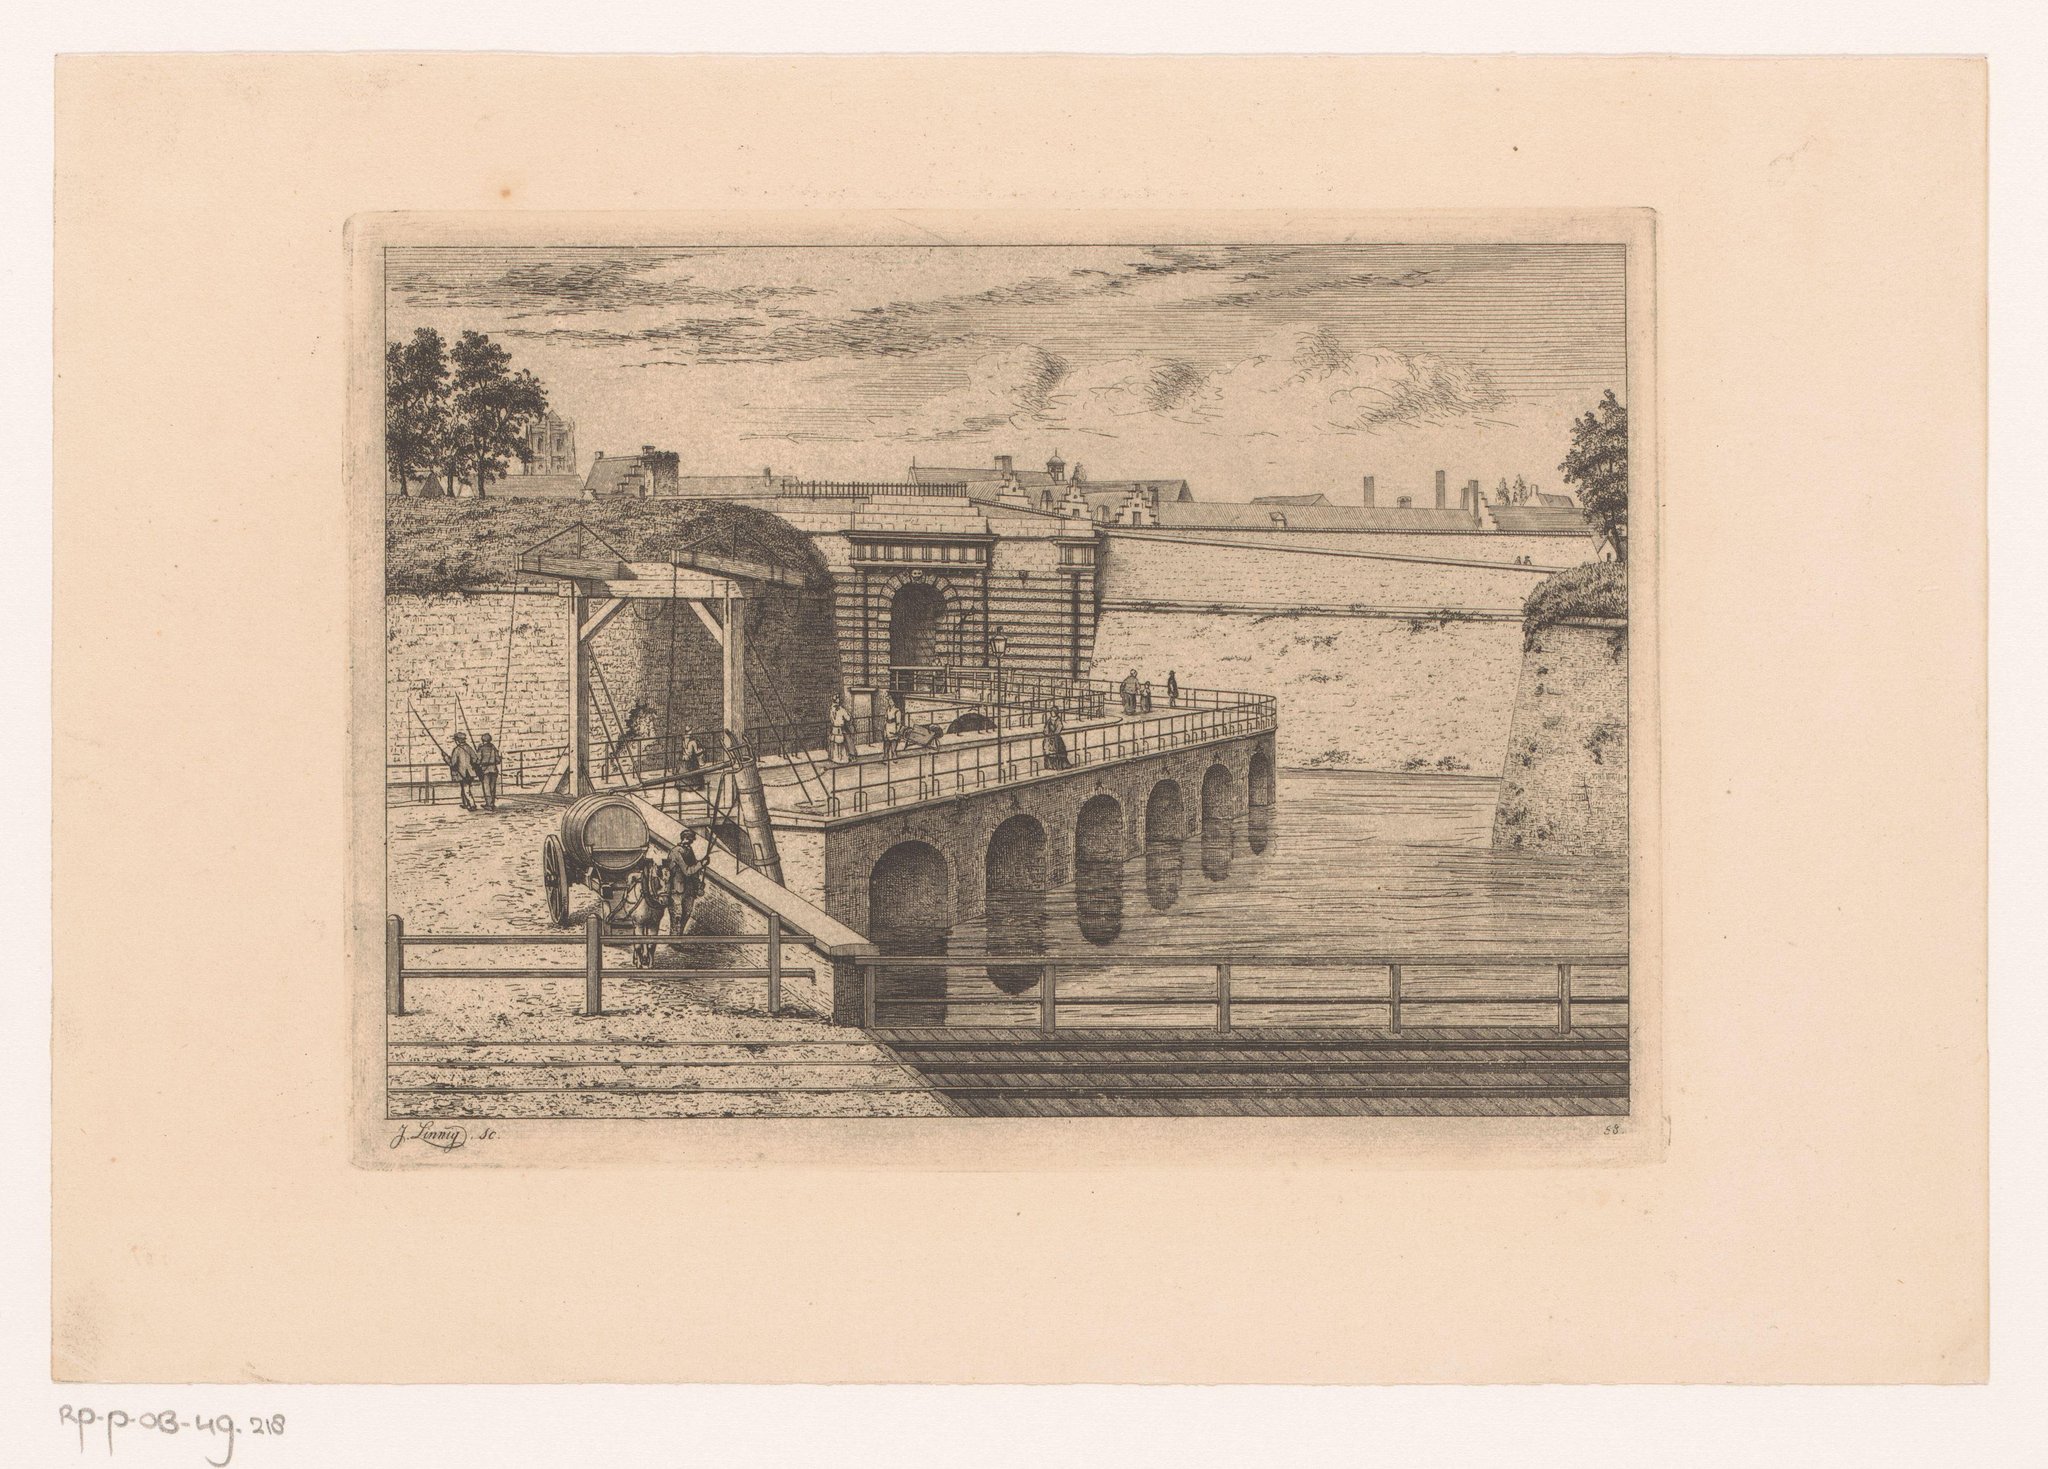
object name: print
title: Gezicht op de voormalige stadspoort Rode Poort in Antwerpen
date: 1868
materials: paper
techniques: etching, intaglio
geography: antwerp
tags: city-gate, antwerp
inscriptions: collector's mark: Lugt 2228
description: Prent uit: Mertens, F.H. Album historique de la ville d'Anvers [...]. Antwerpen: J.E. Buschmann, 1868.